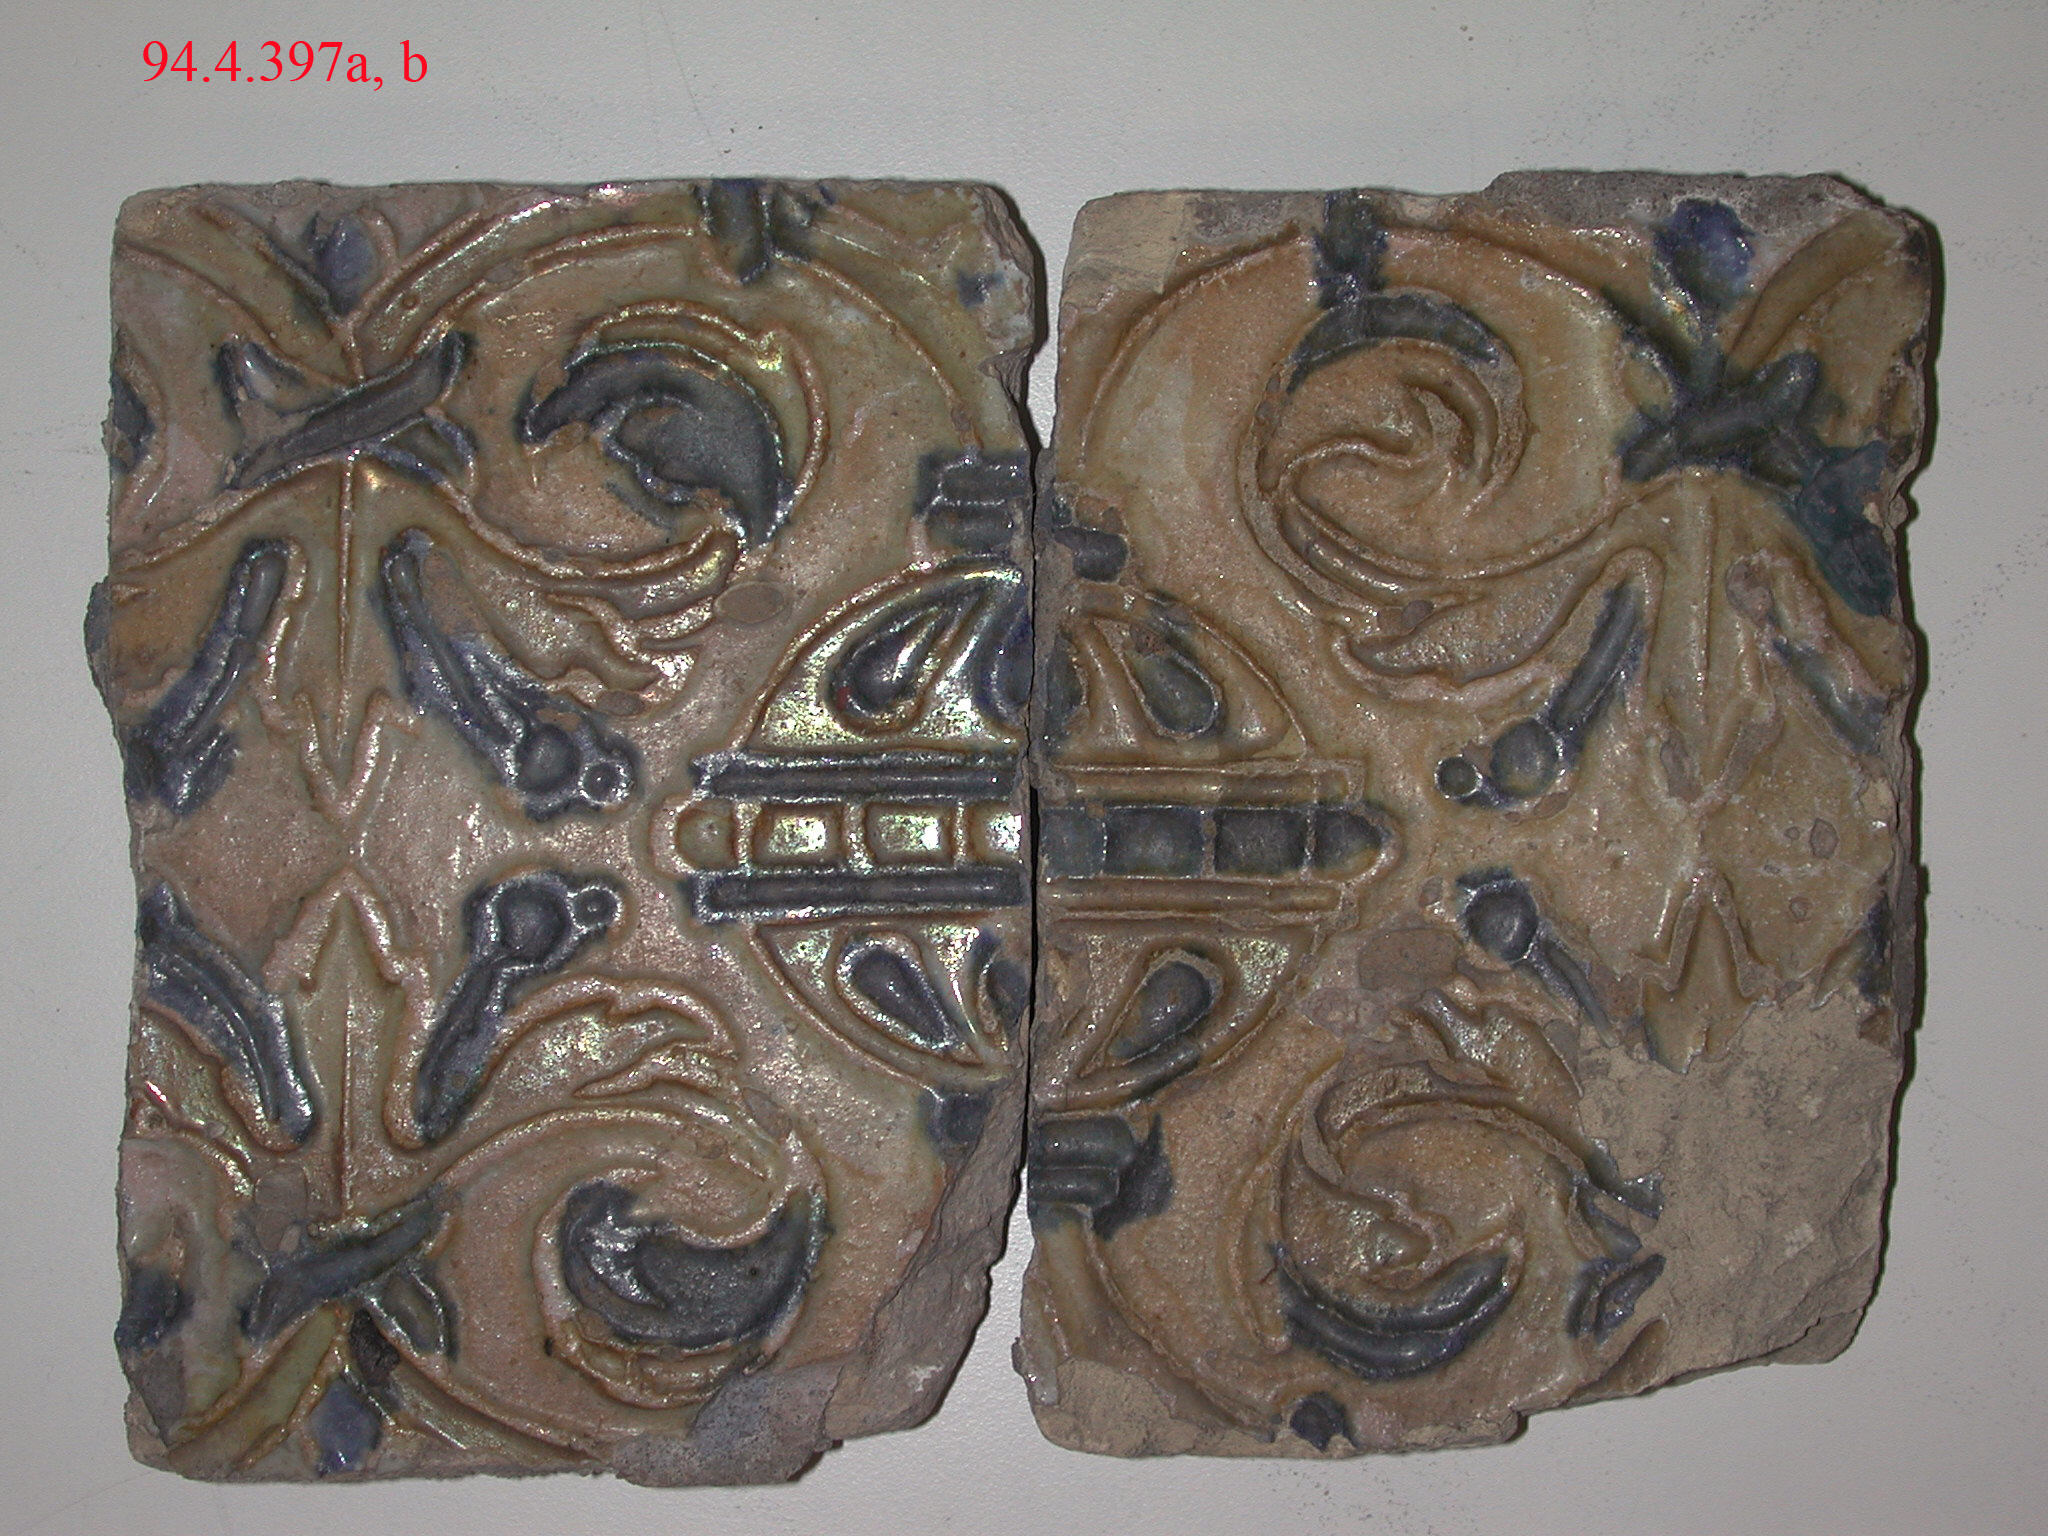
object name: tile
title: Tiles (4)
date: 1501-1700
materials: earthenware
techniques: glazing